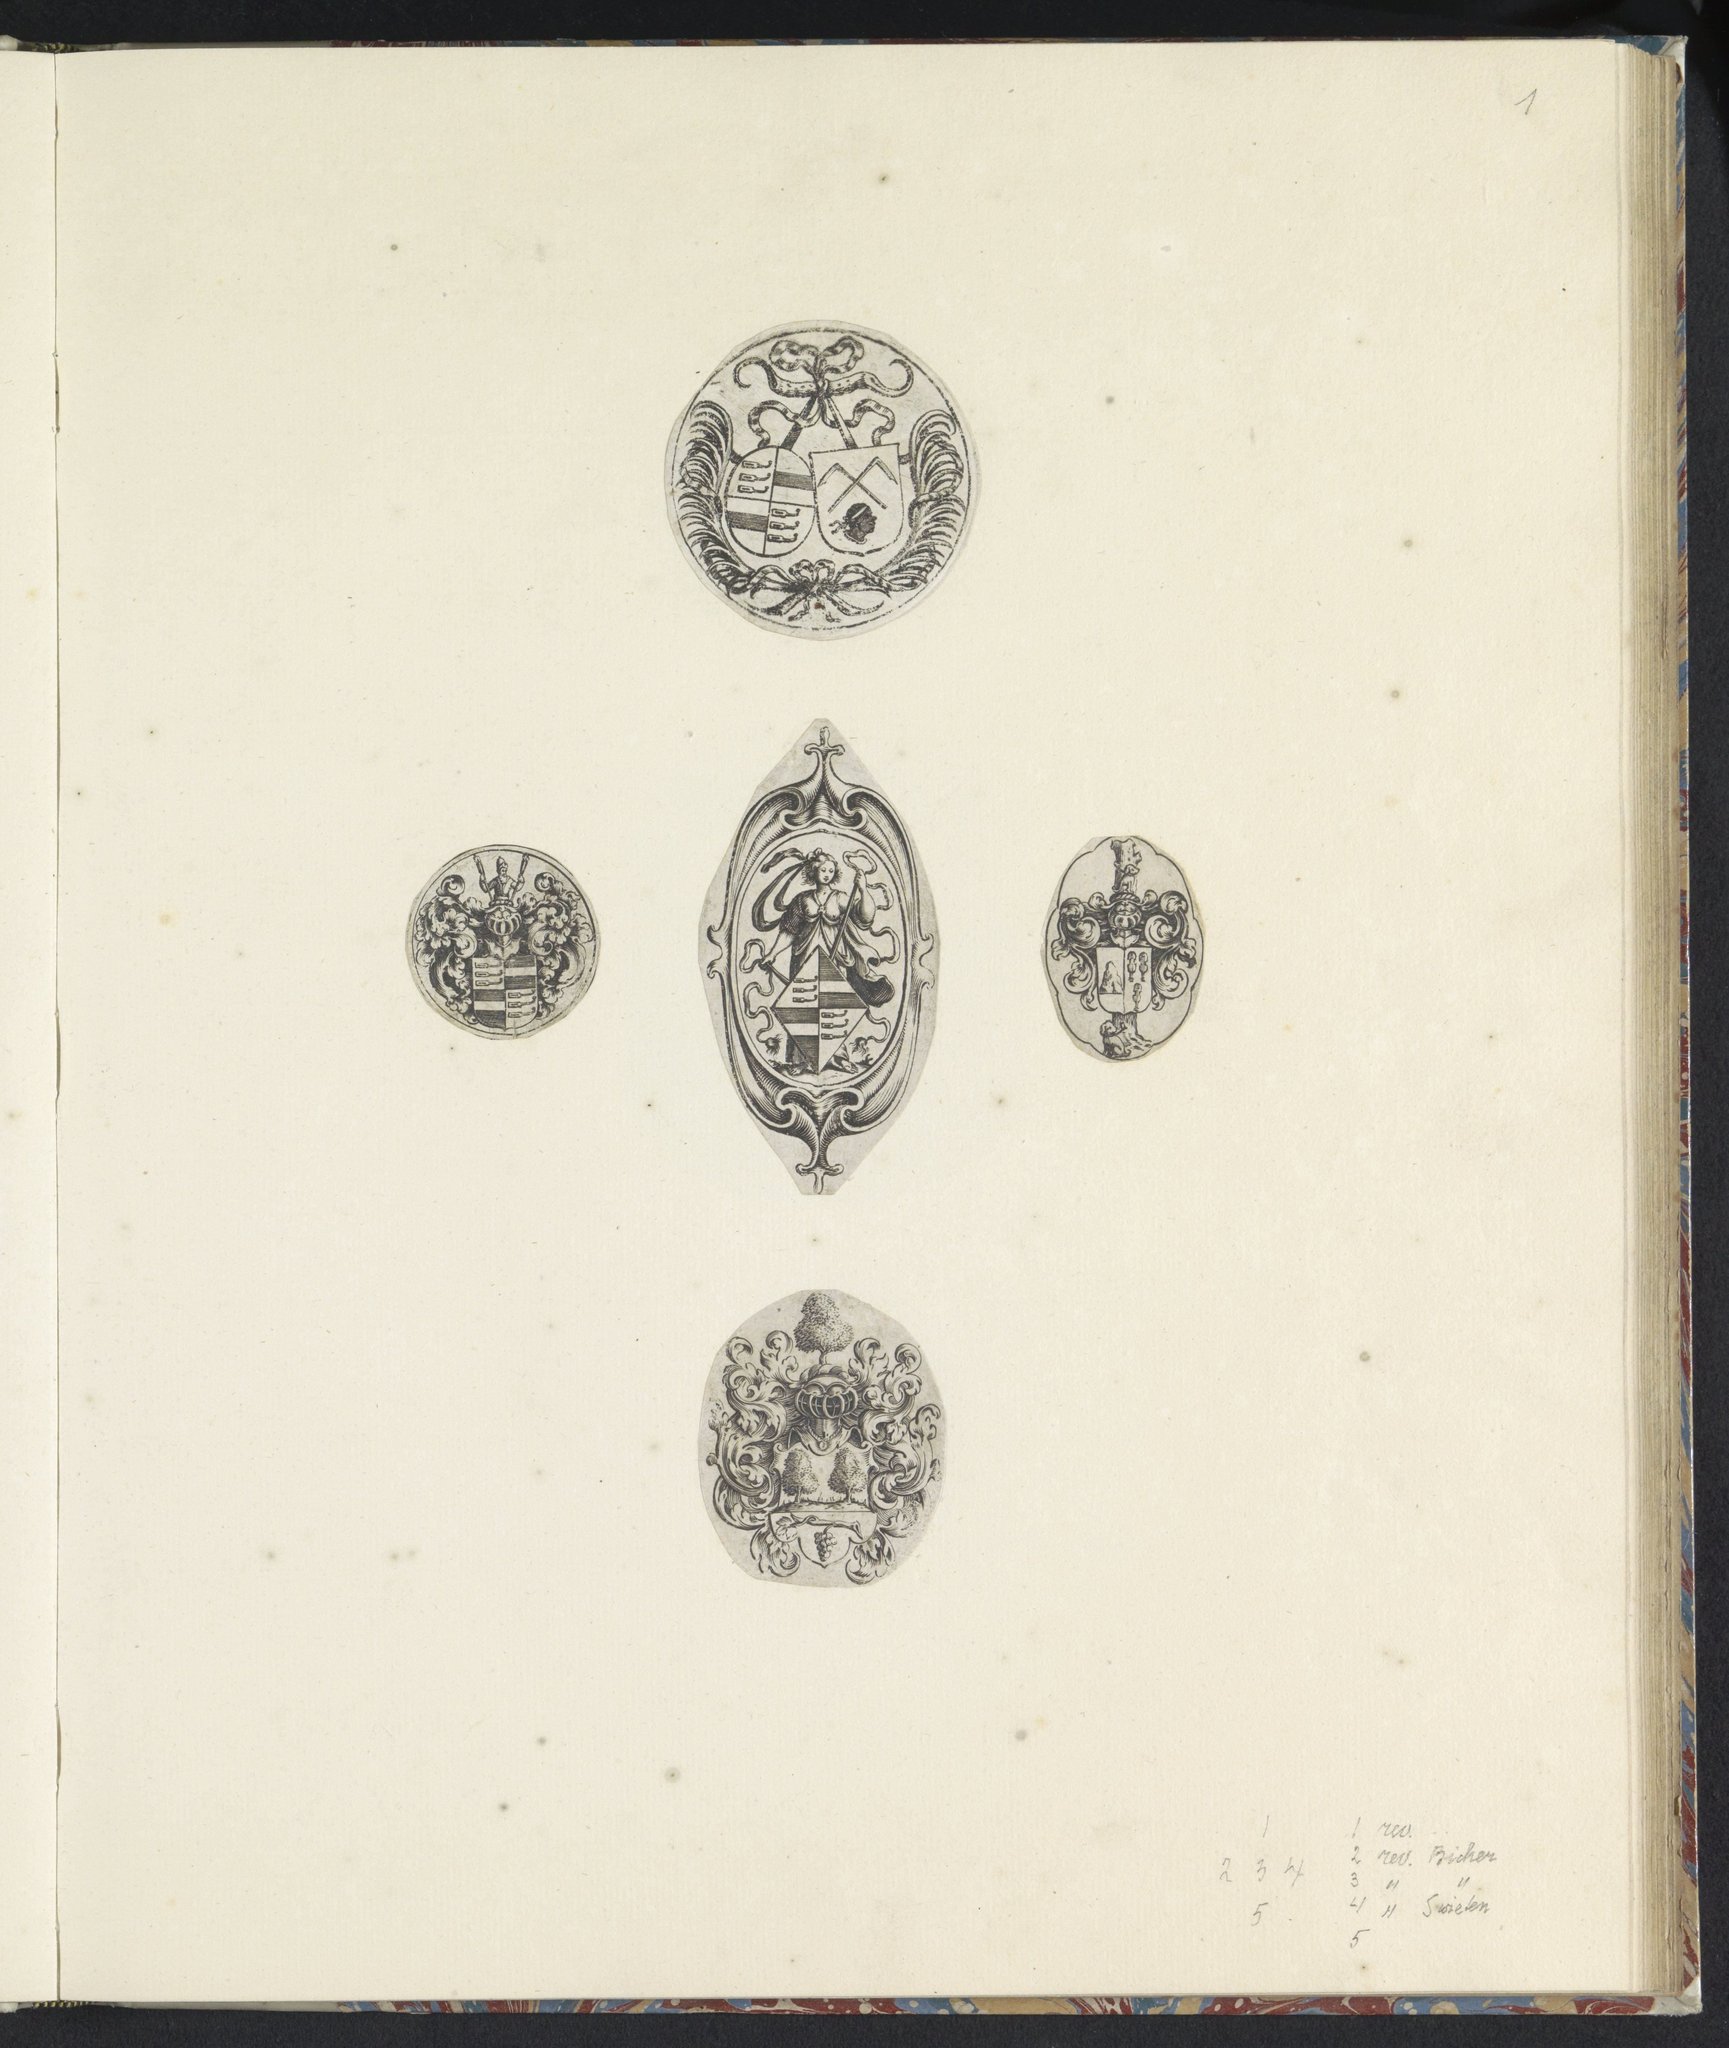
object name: print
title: Vijf wapens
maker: Anonymous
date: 1600-1699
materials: paper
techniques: engraving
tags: armorial bearing, heraldry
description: Vijf voorstellingen op een albumblad. De eerste drie met het wapen van de Amsterdamse familie Bicker: een gevierendeeld schild met in het eerste en laatste kwartier een dwarsbalk en in het tweede en derde kwartier drie helmstokken boven elkaar. Deze is bij de eerste voorstelling gecombineerd met een wapen met twee gekruiste zeisen en een afbeelding van een Moor. Het vierde wapen is gerelateerd aan de familie Van Swieten: drie violen met de stokken naar beneden. Boven en onder een hond. Het vijfde wapen toont een schild met twee bomen en een derde boom als helmteken. Daaronder een druiventak. De prenten maken deel uit van een album.